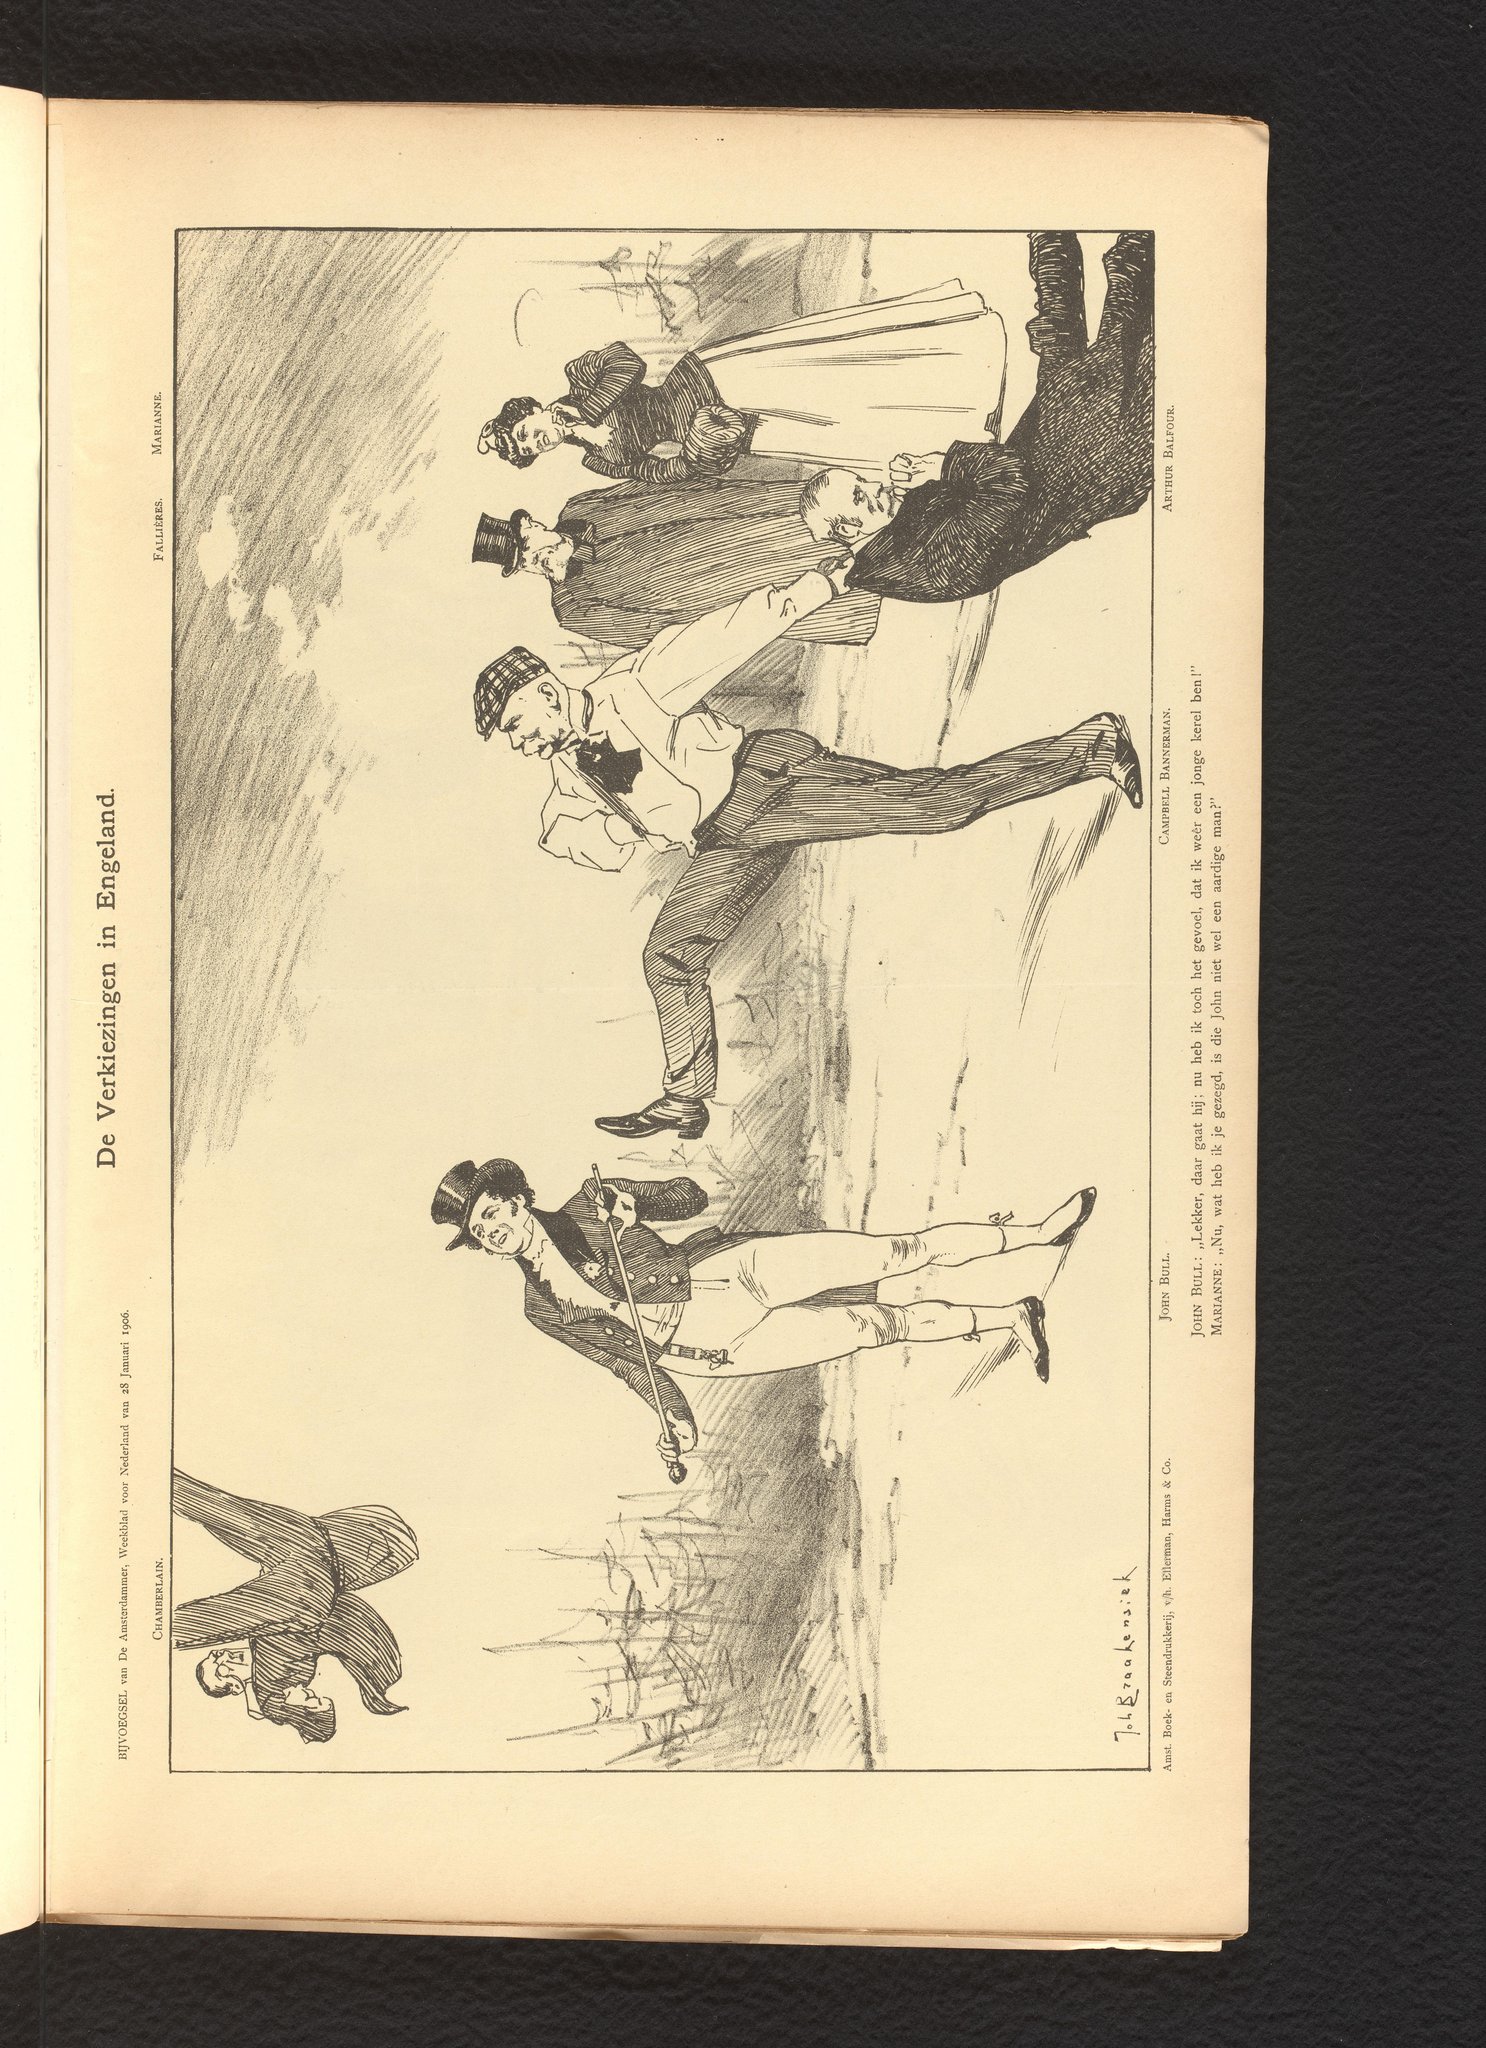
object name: cartoon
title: De Verkiezingen in Engeland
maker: johan braakensiek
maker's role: draughtsman, print maker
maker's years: 1858-1940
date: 1906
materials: paper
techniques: lithograph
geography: amsterdam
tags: voting, election, personifications of countries, nations, states, districts, etc., kicking, political caricatures and satires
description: Een afgeslankte John Bull (Engeland) ziet tevreden hoe Henry Campbell-Bannerman Joseph Chamberlain een enorme trap verkoopt. Arthur Balfour lijkt het volgende slachtoffer te worden. Marianne (Frankrijk) kijkt met de Franse president Armand Fallières toe. Naar aanleiding van de grote overwinning van de liberalen onder Campbell-Bannerman bij de verkiezingen in 1906.